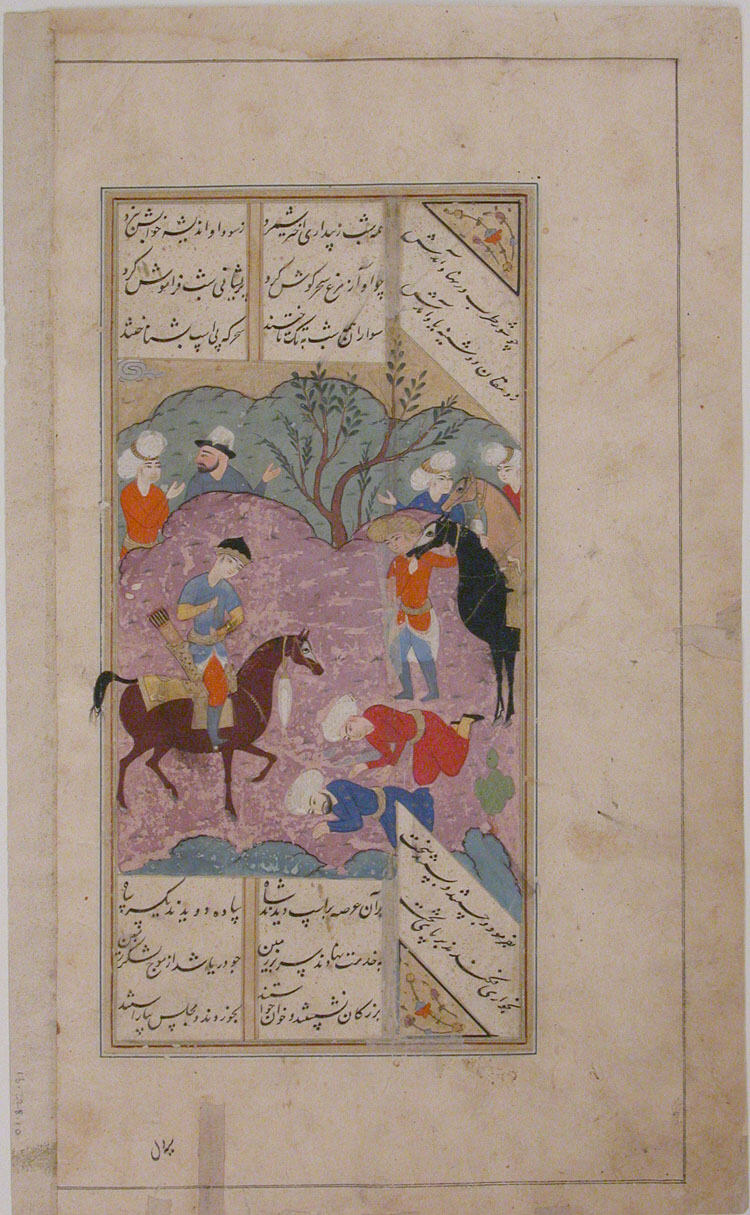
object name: folio from an illustrated manuscript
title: "The Servants of One of the Monarchs of Ghur Make Obeisance Before Him", Folio from a Kulliyat (Complete Works) of Sa'di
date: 1801-1900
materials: gold, ink, paper, watercolor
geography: india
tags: men,horses